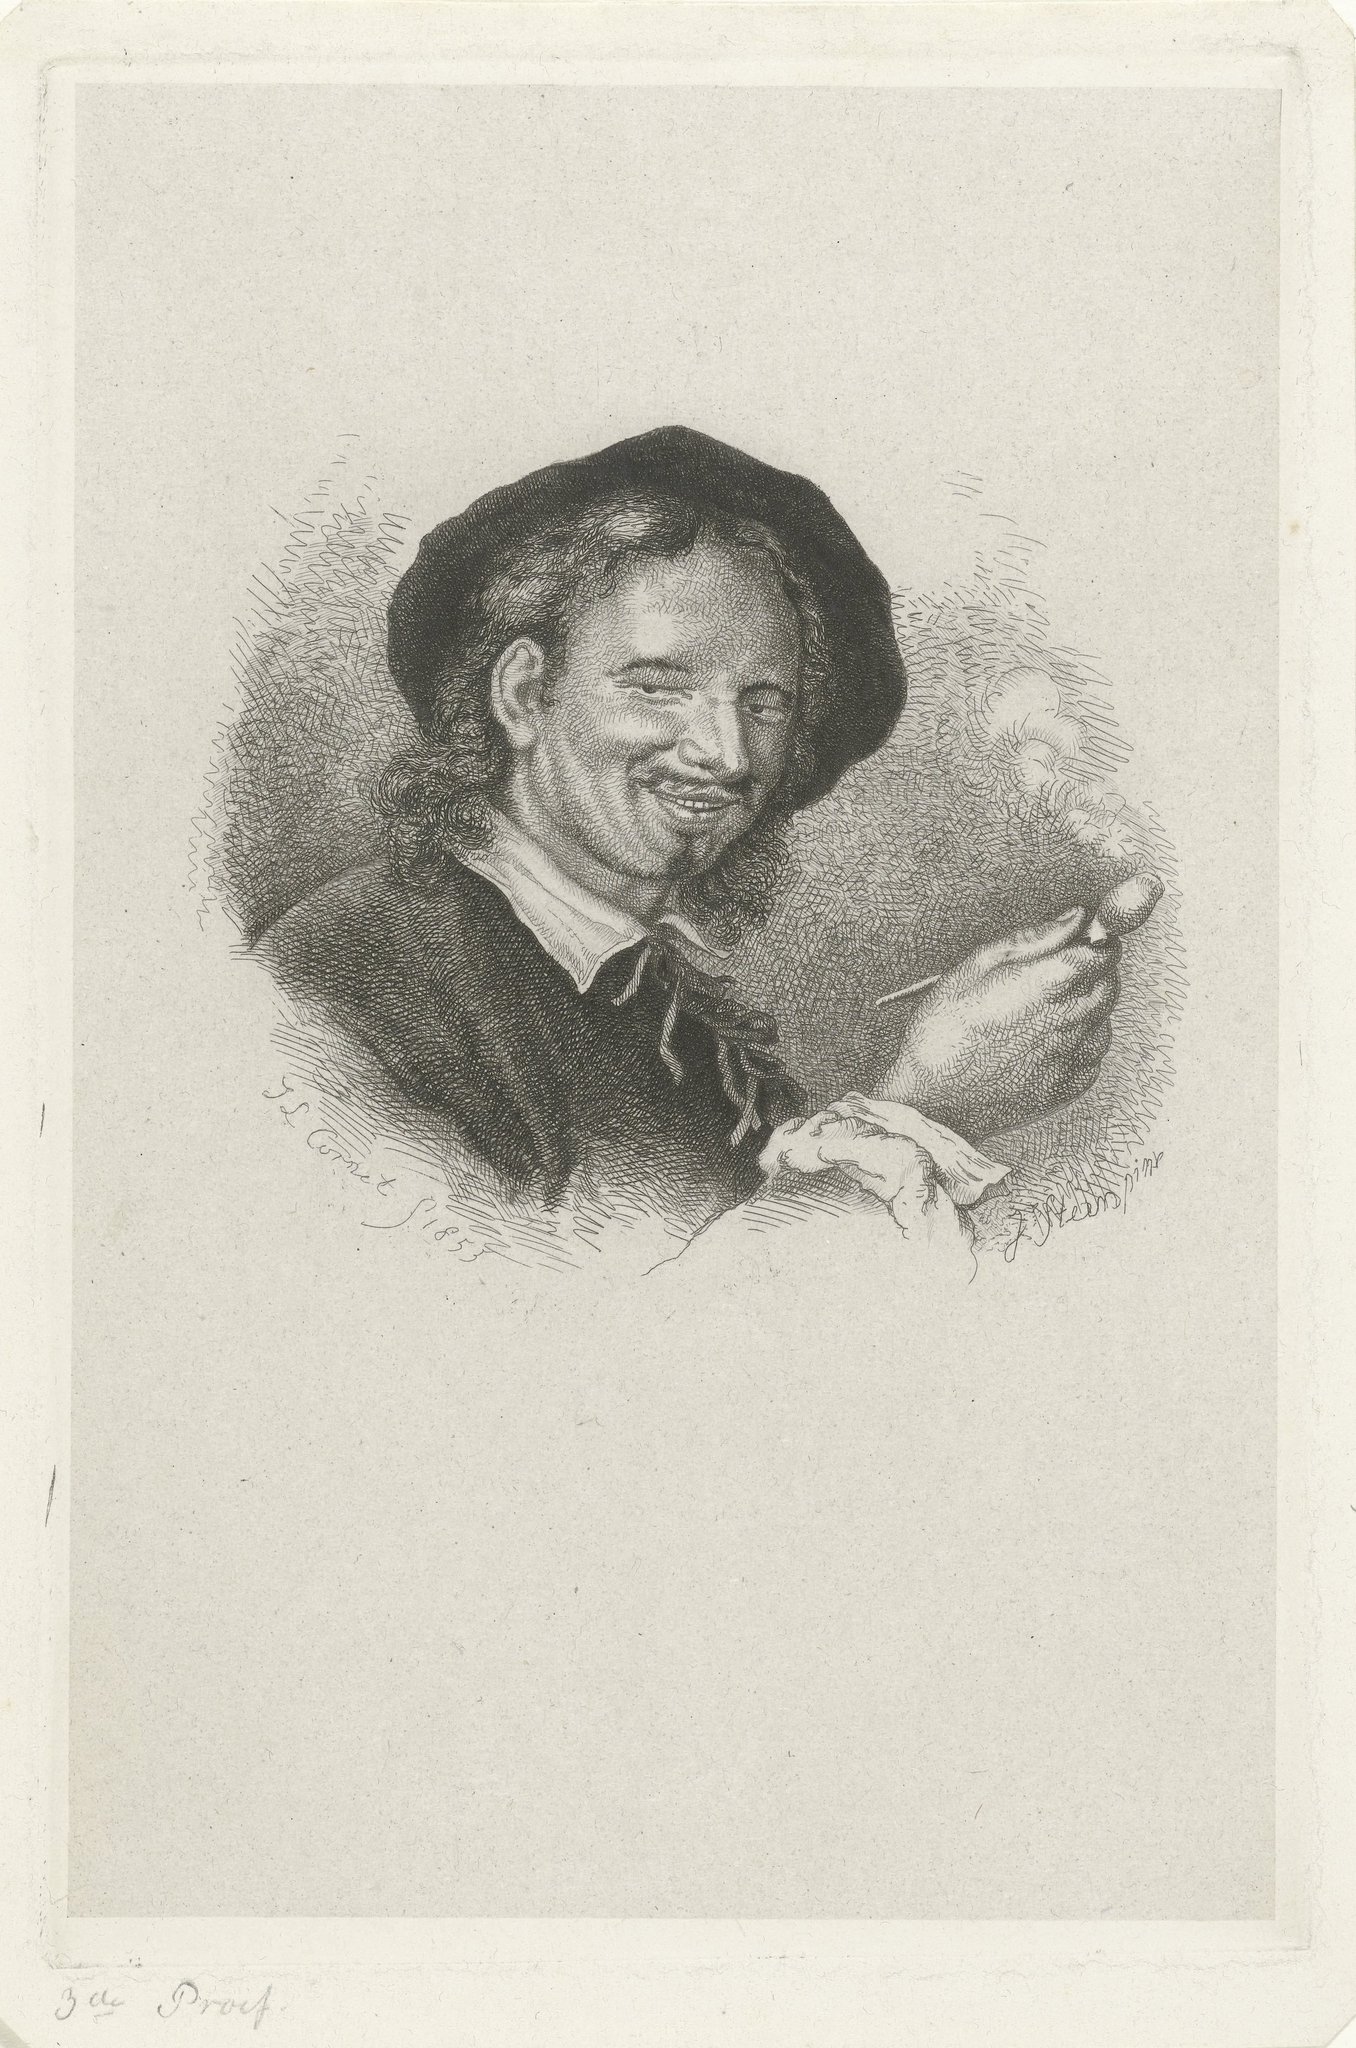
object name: print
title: Portret van Jan Steen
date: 1854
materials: paper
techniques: etching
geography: leiden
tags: leiden, painter, jan havicksz. steen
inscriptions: caption: ‘3ste proef’, collector's mark: Lugt 2228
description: Portret van de schilder Jan Steen. Steen draagt een hoed en heeft een pijp in de hand. Buste naar rechts.